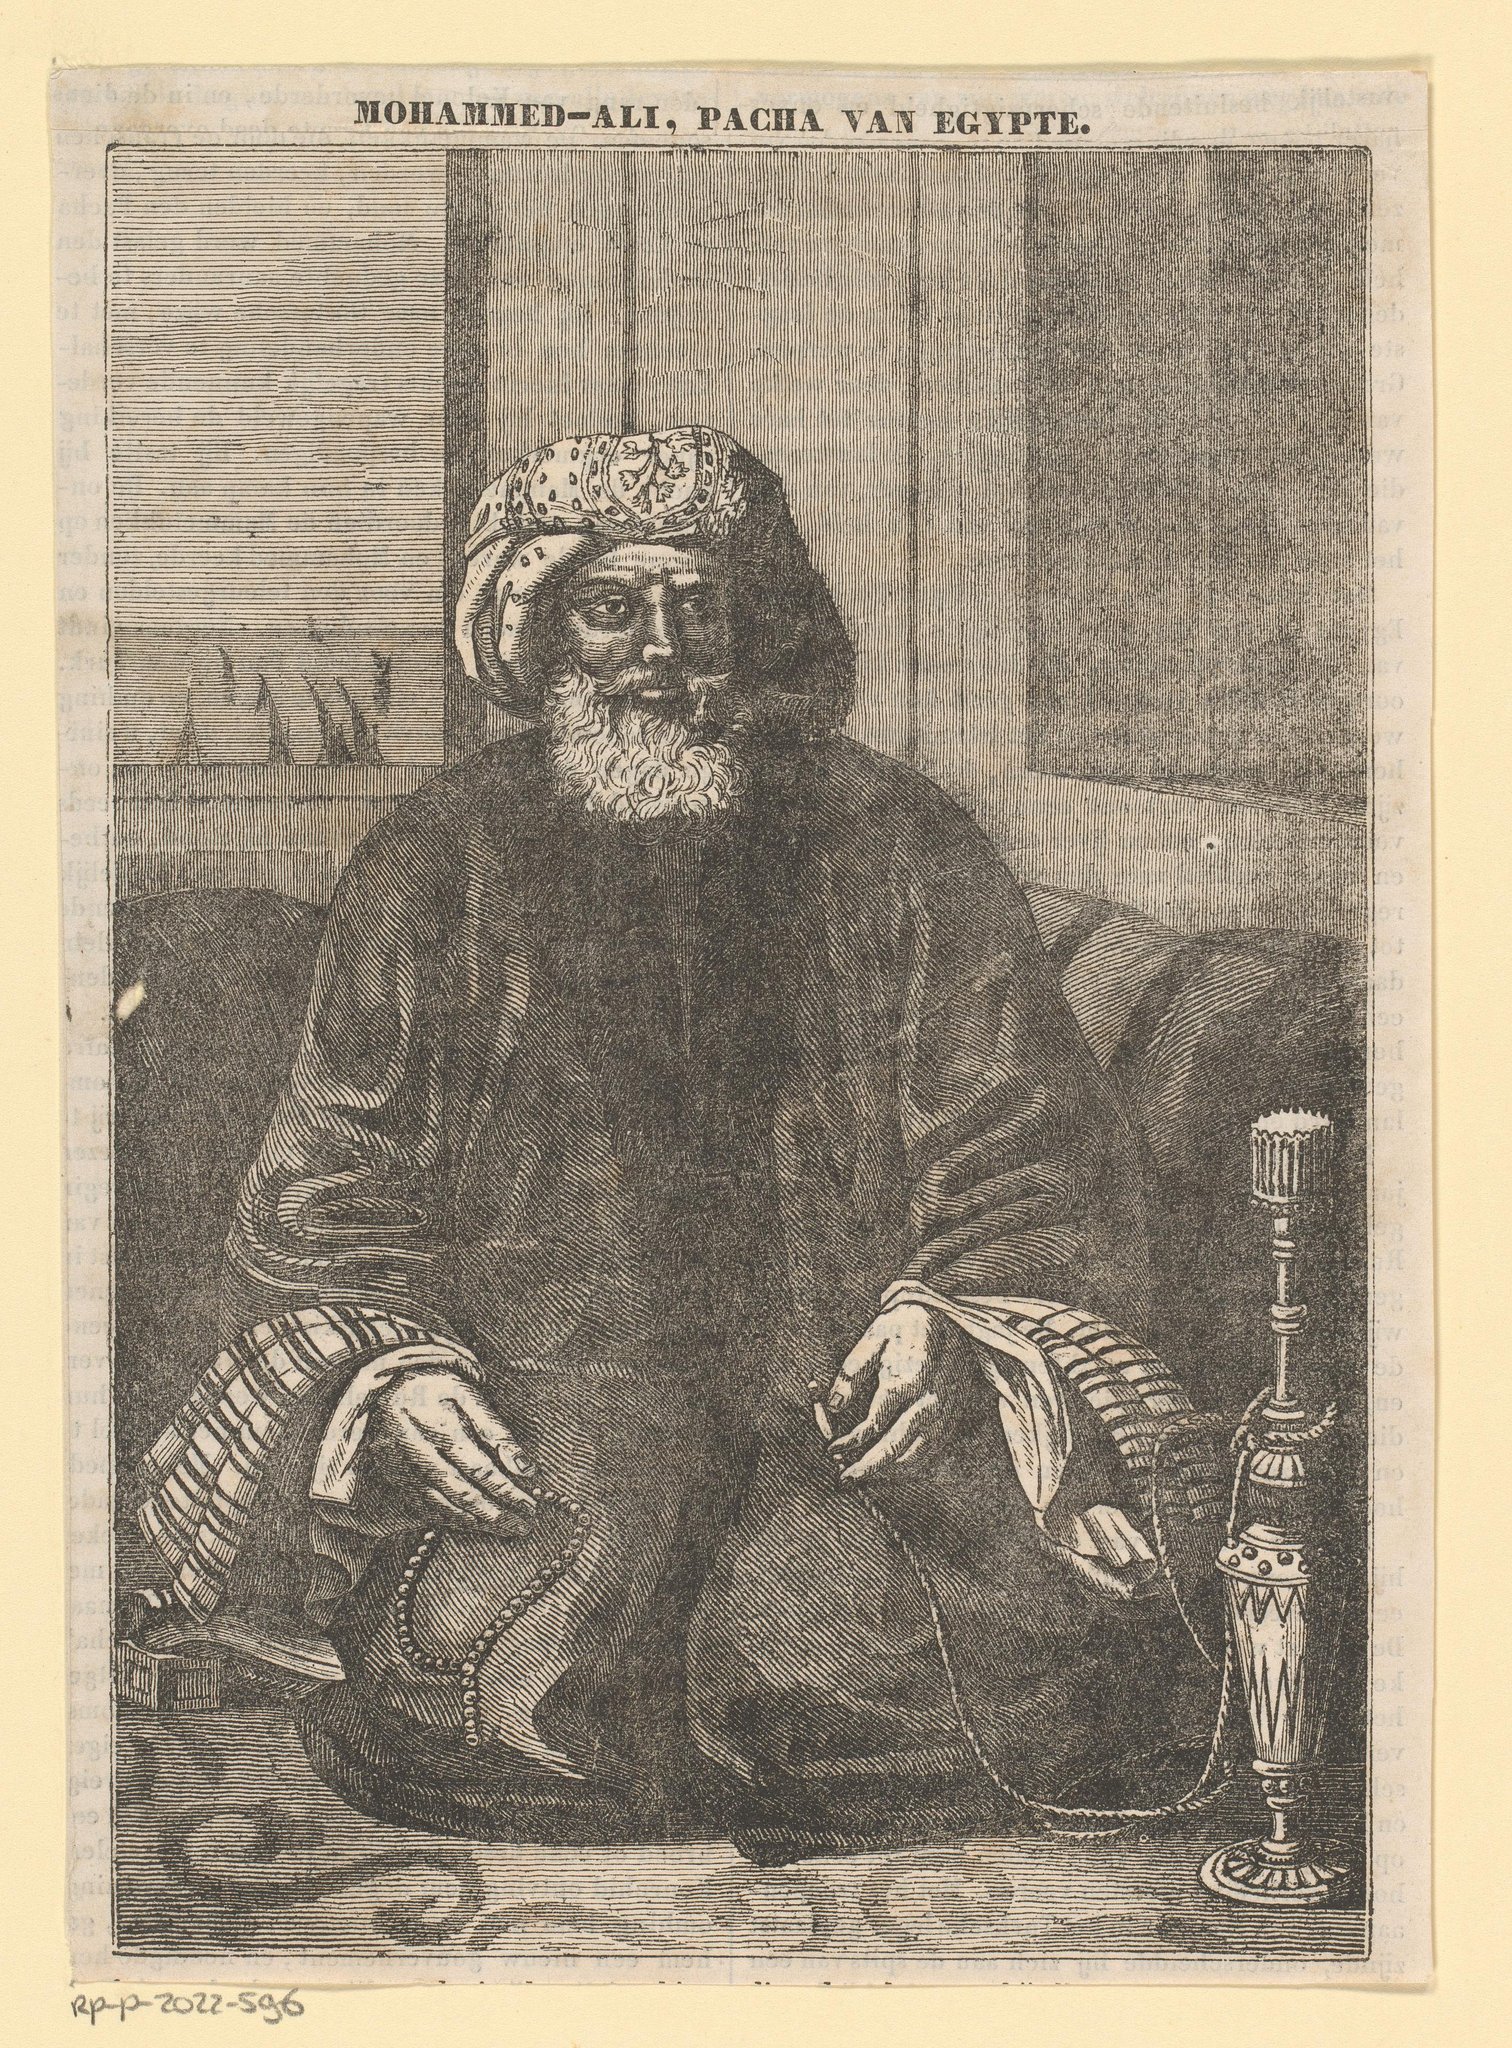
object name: print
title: Portret van Mohammed Ali, gouverneur van Egypte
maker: Anonymous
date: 1837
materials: paper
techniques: letterpress printing, snipping, engraving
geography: amsterdam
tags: historical persons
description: Prent uit: Nederlandsch magazijn ter verspreiding van algemeene en nuttige kundigheden. Amsterdam: Gebroeders Diederichs, 1837, p. 129.